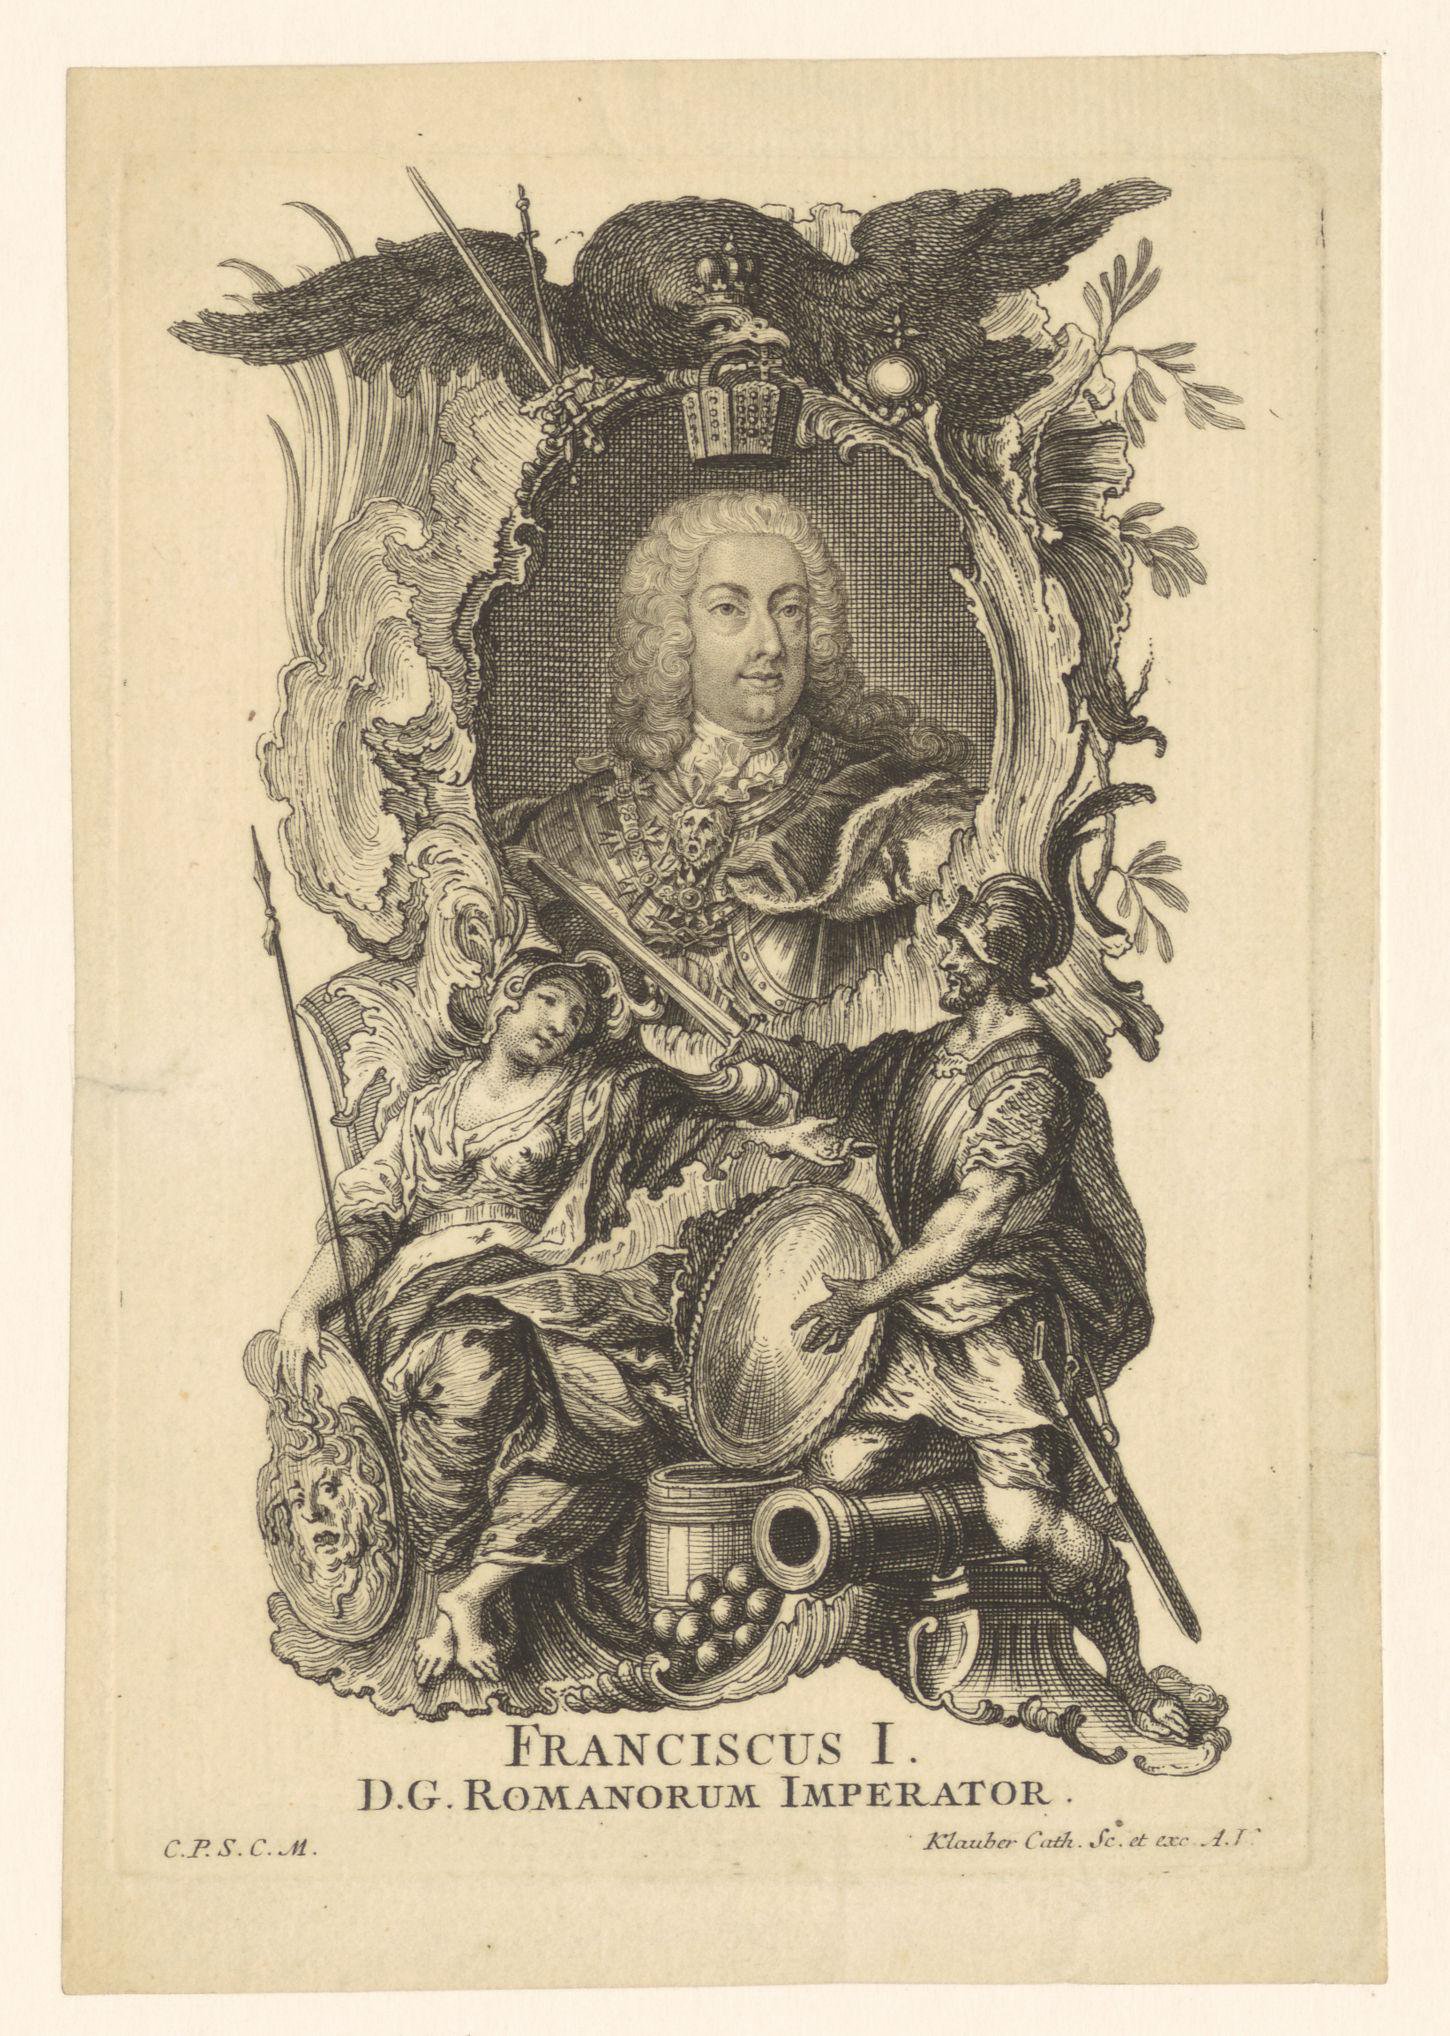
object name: print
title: Portret van keizer Frans I Stefan met allegorie op strijdkracht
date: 1750-1817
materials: paper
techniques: engraving, etching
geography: augsburg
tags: frans i stefan (duits keizer), fortitude, 'fortitudo' ~ one of the four cardinal virtues, historical persons, pope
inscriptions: collector's mark: Lugt 2228